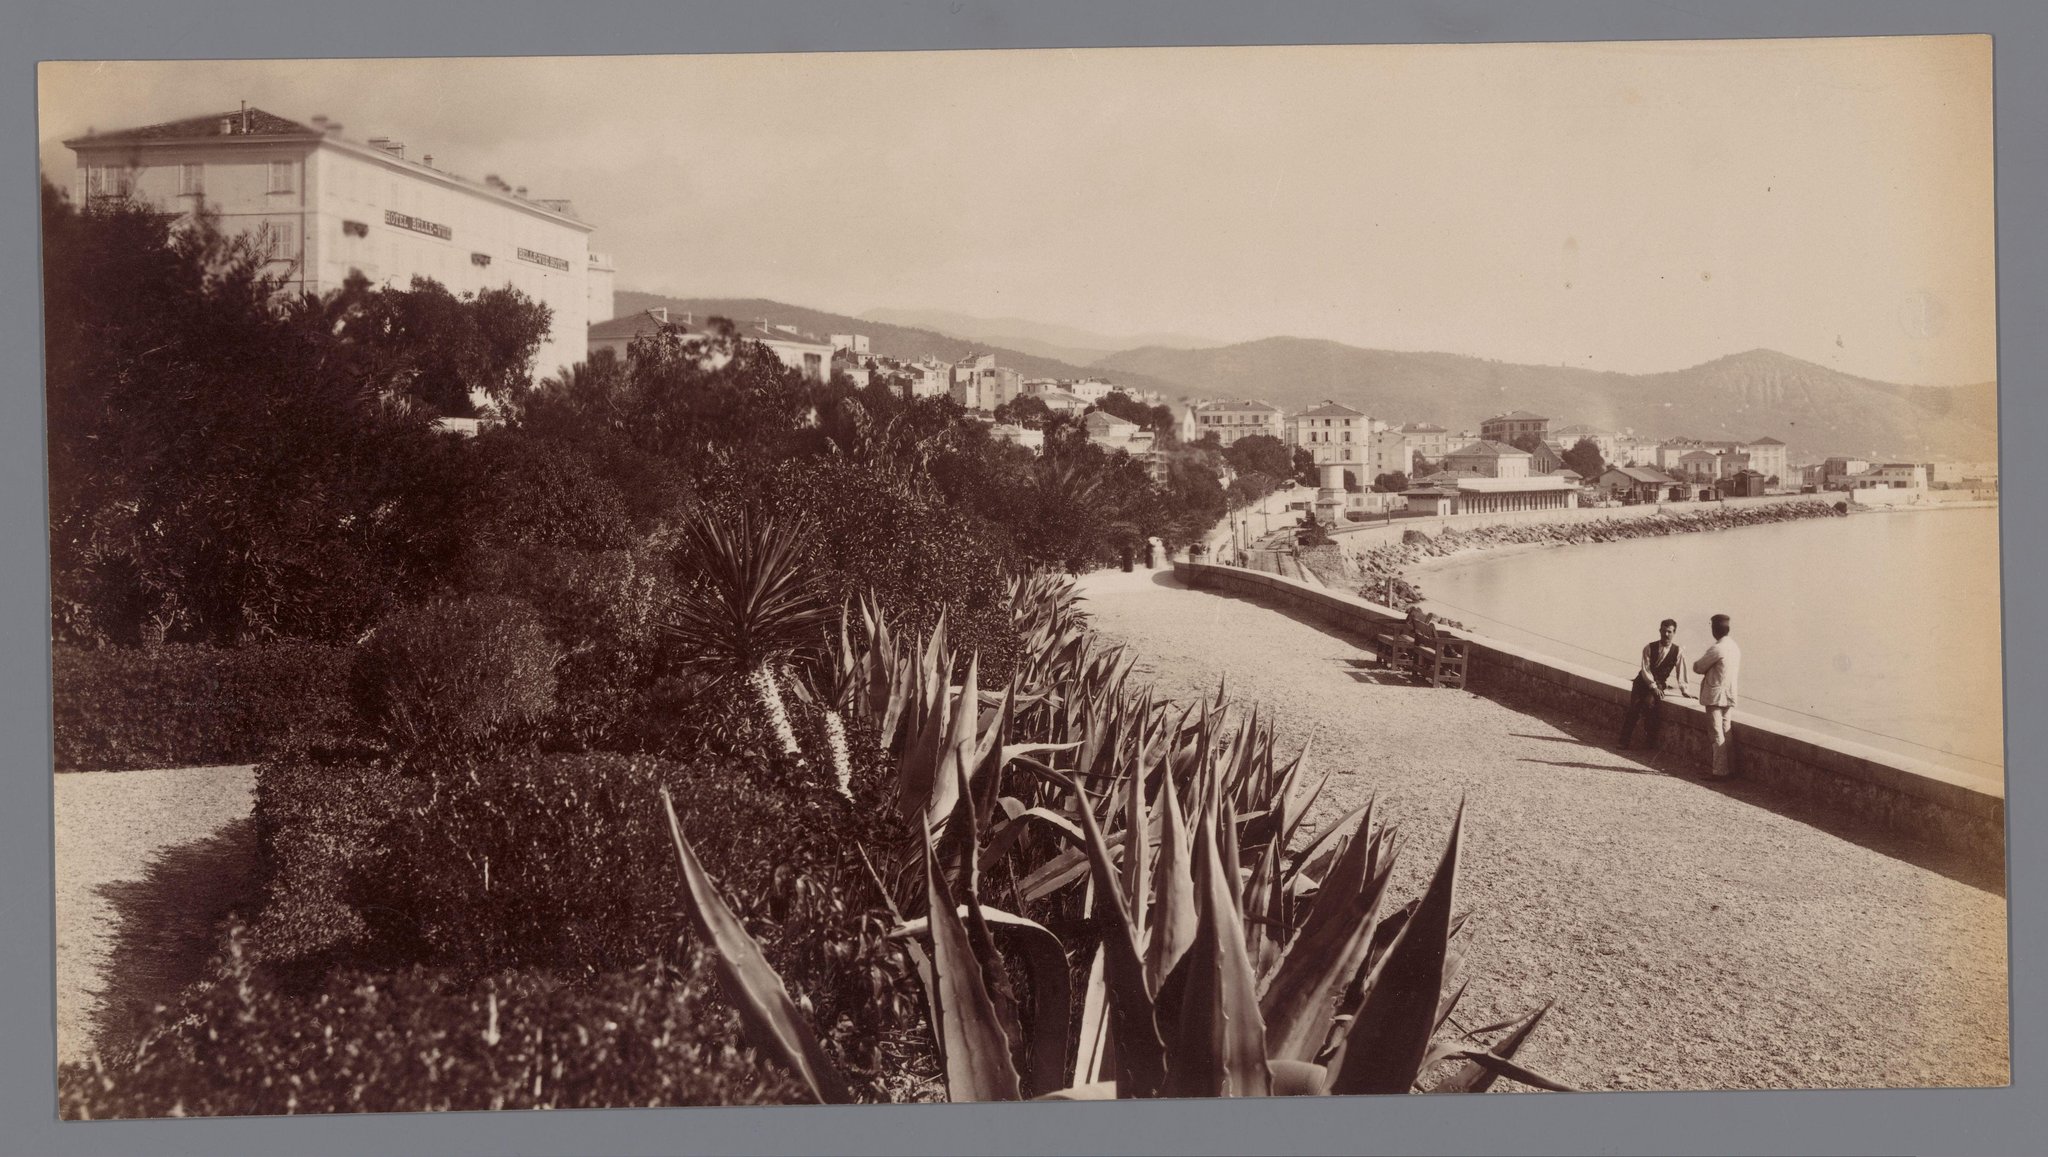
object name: photograph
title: San Remo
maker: Anonymous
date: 1851-1900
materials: paper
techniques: albumen print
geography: san remo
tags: gulf, bay, prospect of city, town panorama, silhouette of city